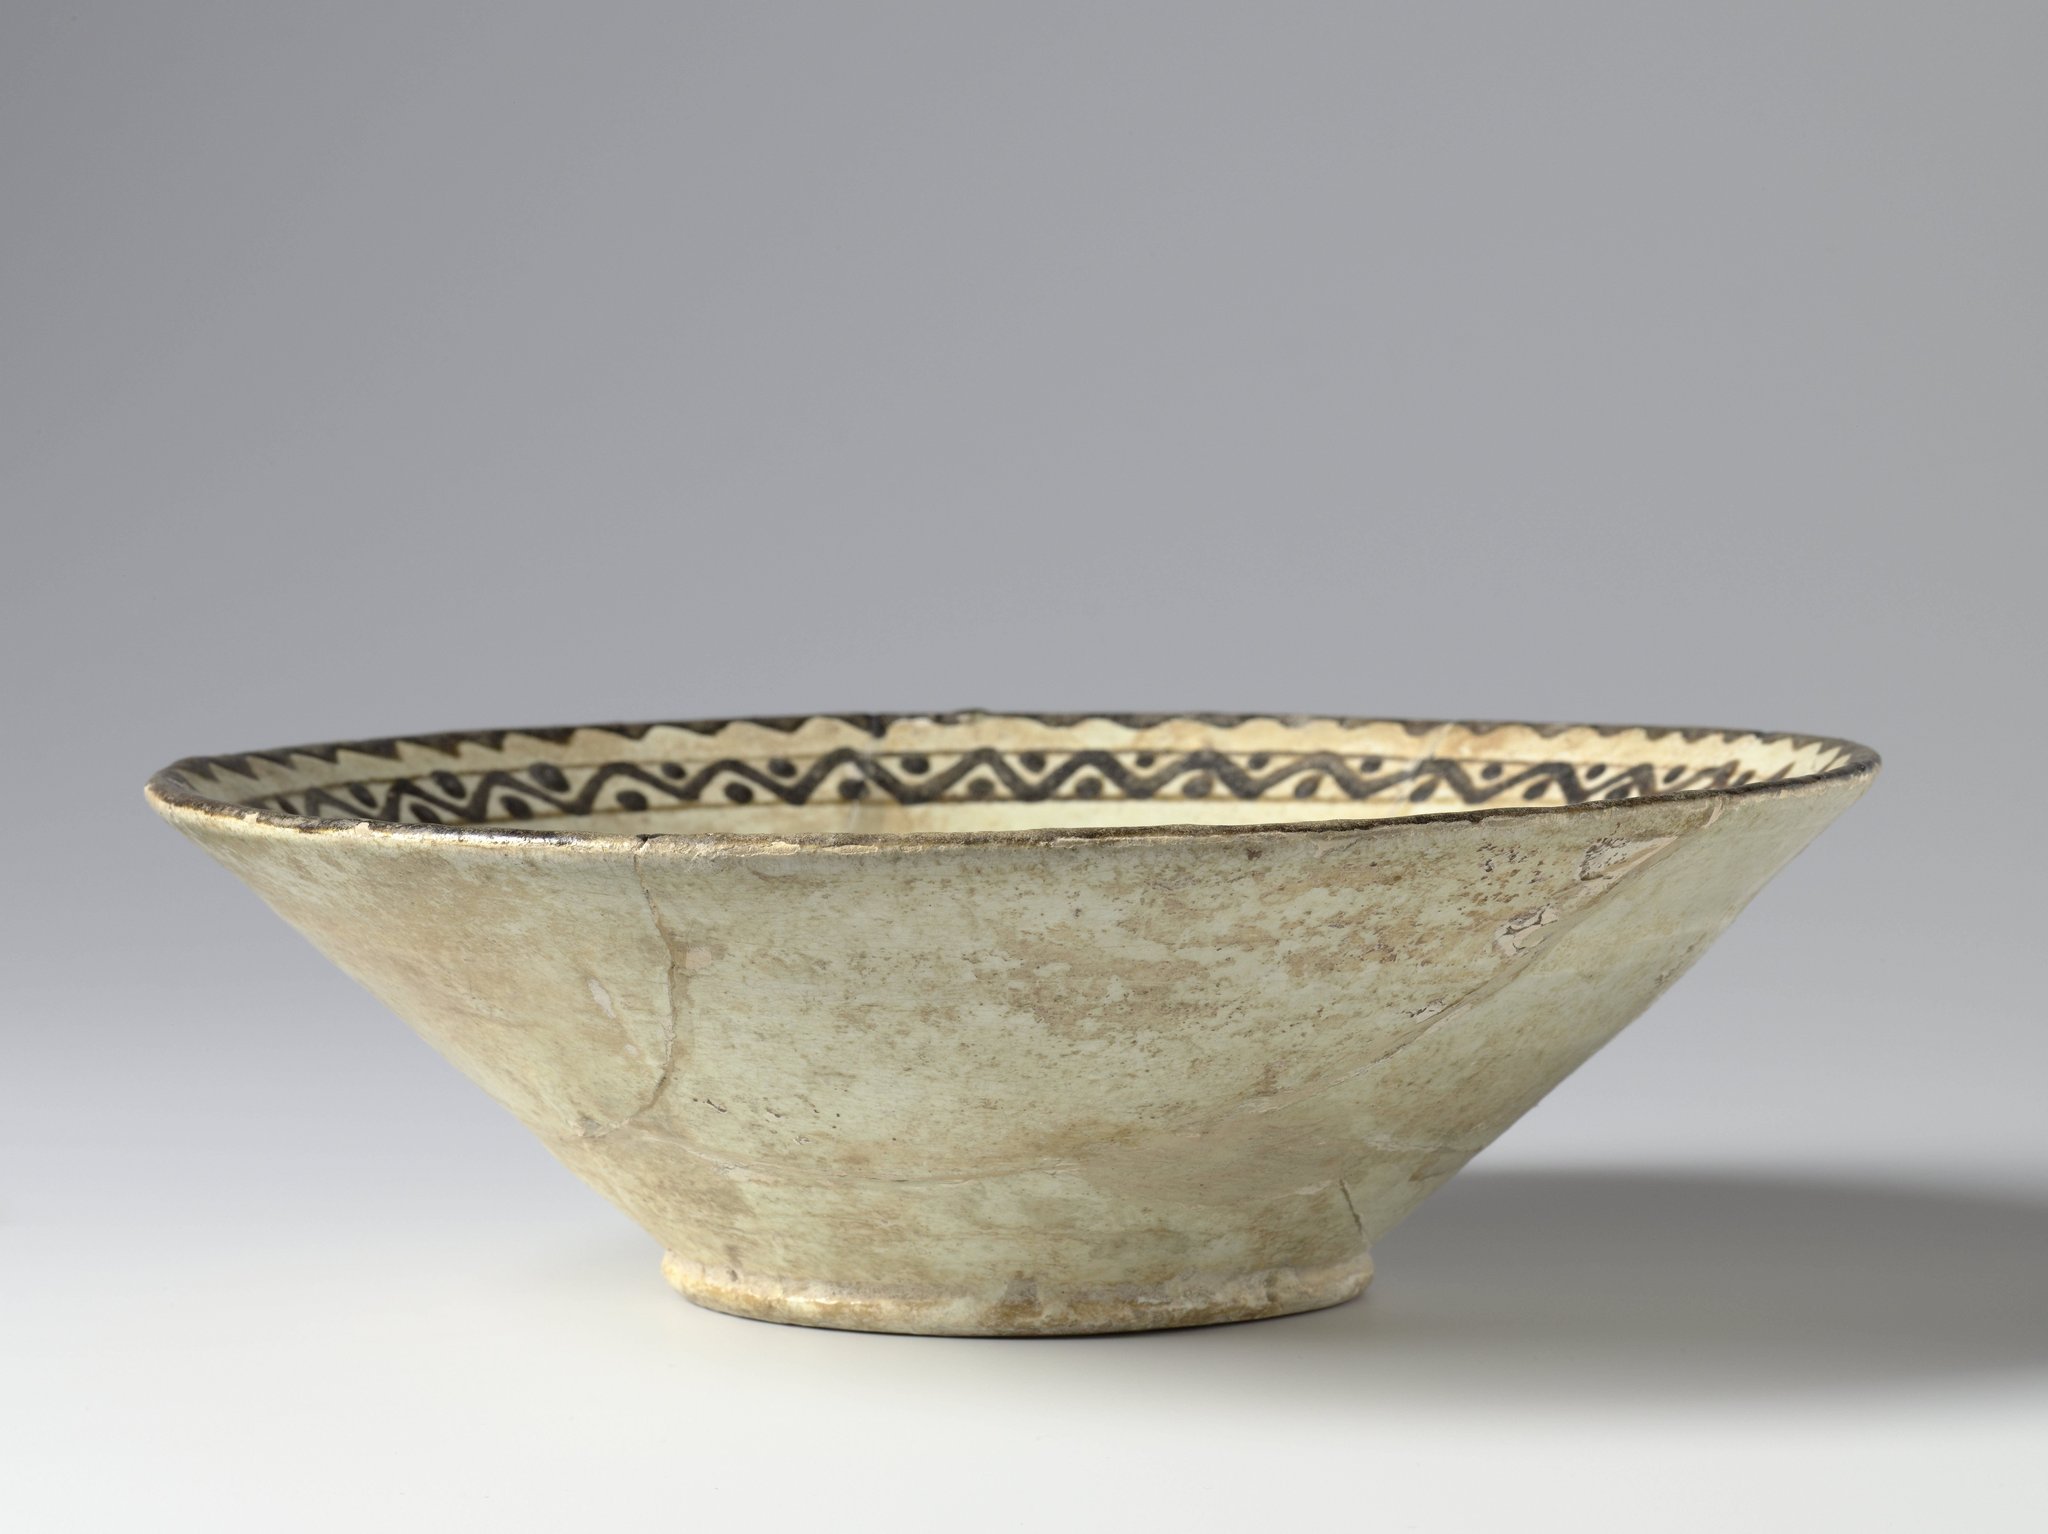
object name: bowl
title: Bowl with ornamental borders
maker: Anonymous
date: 900-999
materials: earthenware, glaze, paint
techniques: firing, turning, vitrification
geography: nishapur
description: Kom van aardewerk met witte slib en een beschildering in zwarte slib onder een transparant loodglazuur. Op de binnenrand twee decoratieve banden.